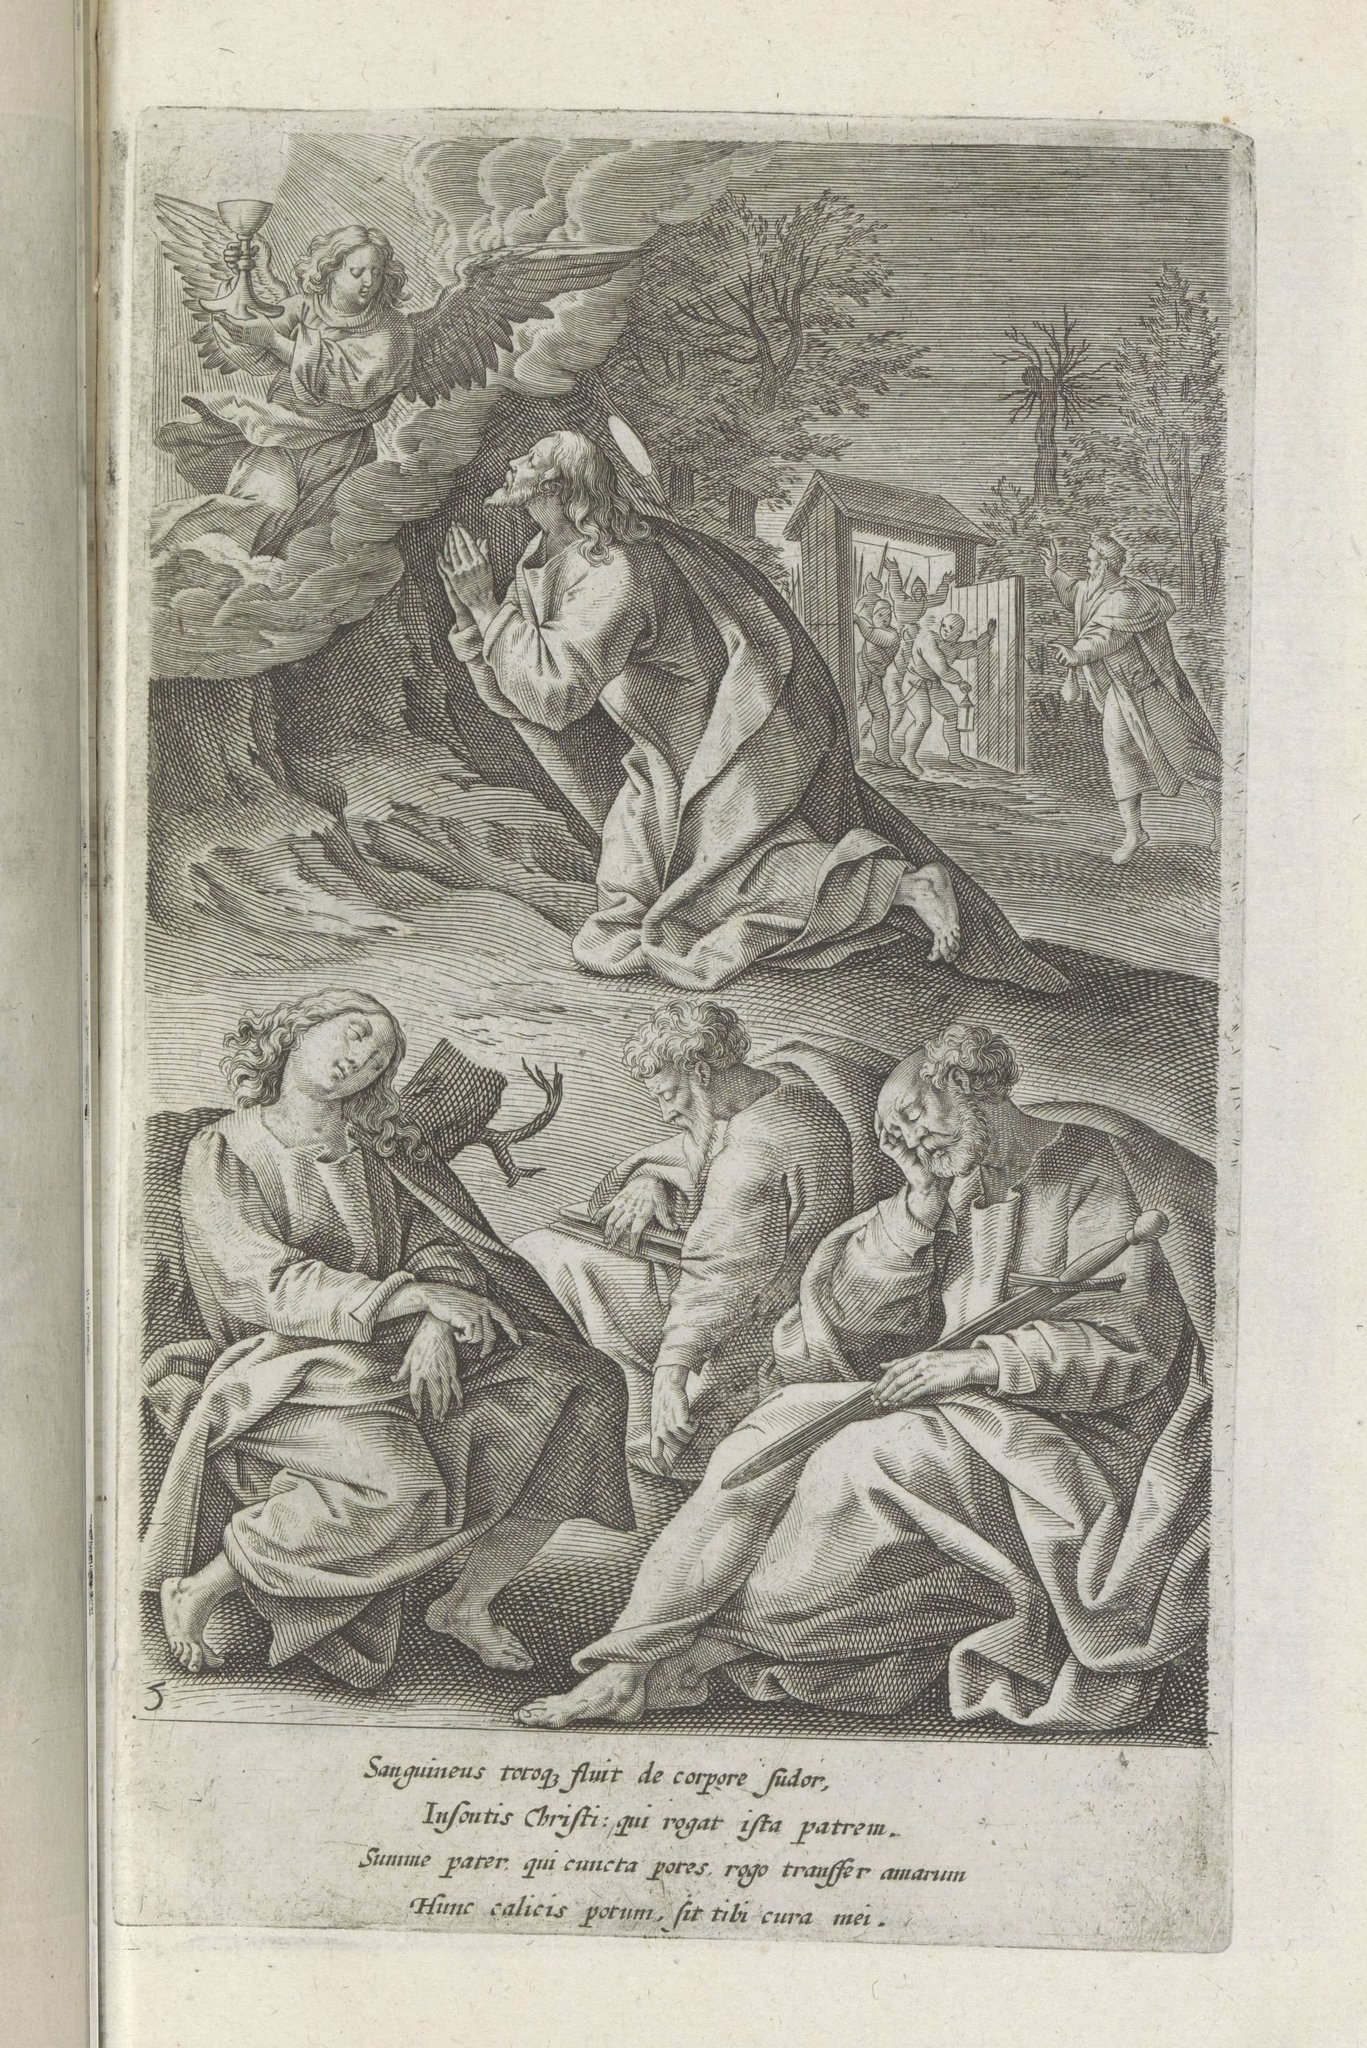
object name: print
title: Leven en passie van Christus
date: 1585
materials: paper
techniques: engraving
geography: antwerp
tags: agony of christ; three (or eleven) apostles sleeping, christ's prayer in the garden of gethsemane during the night, agony of christ: to comfort him one or more angels appear to christ with chalice and/or cross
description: Christus bidt in de hof van Getsemane. Uit de hemel verschijnt een engel met een kelk. Op de voorgrond slapen Petrus, Johannes en Jacobus. Op de achtergrond leidt Judas een groep soldaten door de poort naar binnen. Onder de voorstelling een vierregelig vers in het Latijn. Deze prent maakt deel uit van een album.